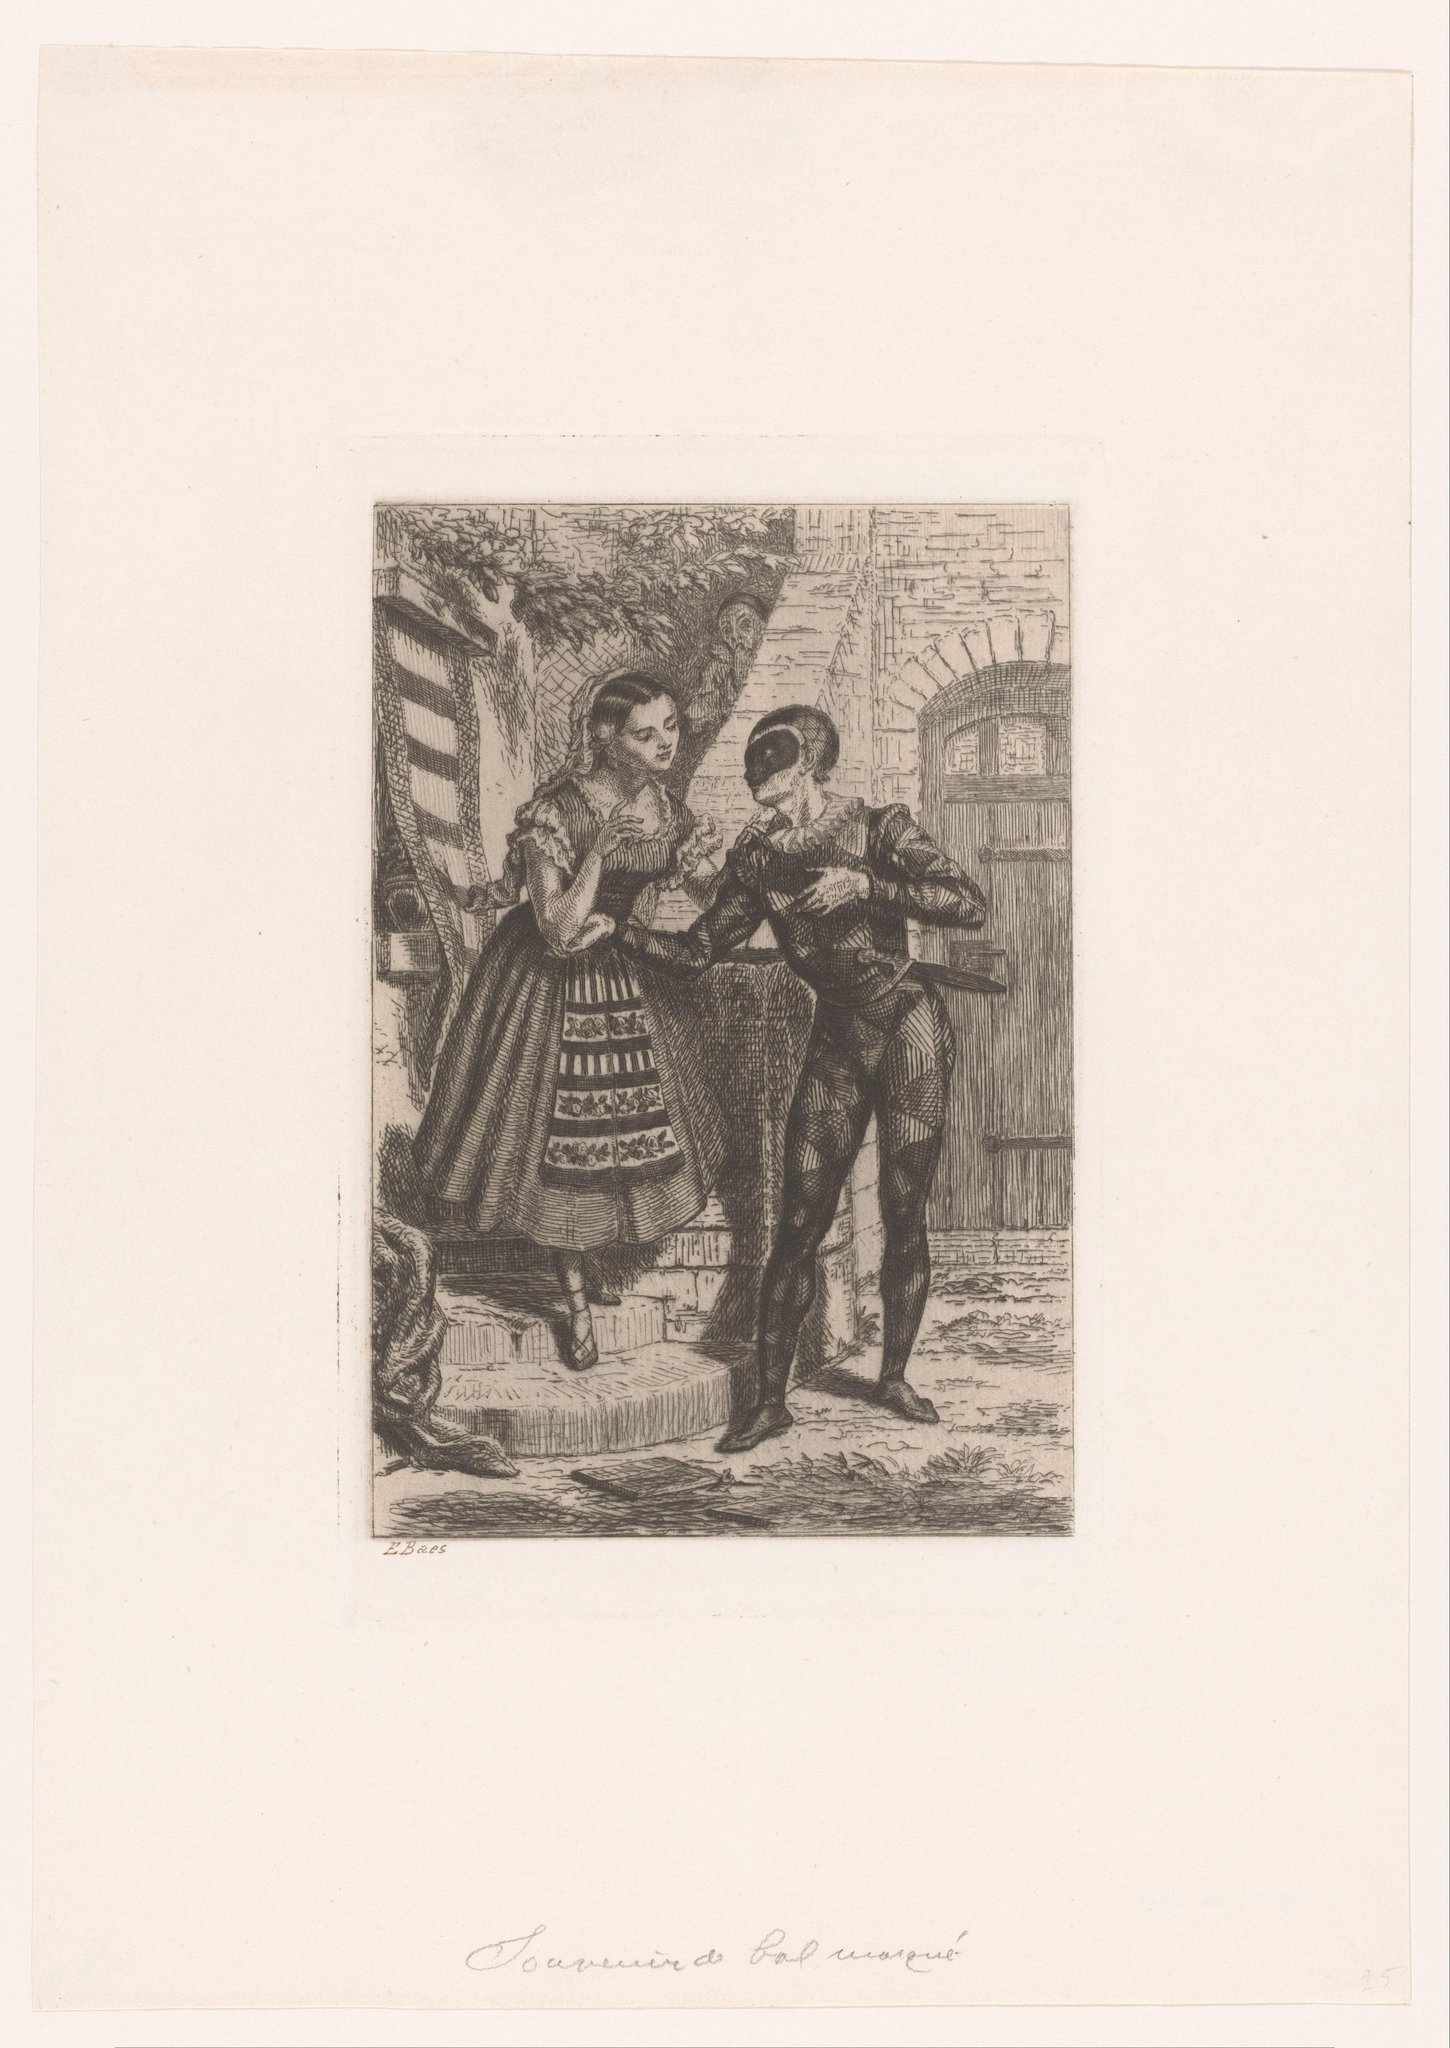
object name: print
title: Harlekijn in domino maakt een meisje het hof, Pierrot kijkt toe van de achtergrond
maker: edgar alfred baes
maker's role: print maker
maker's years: 1837-1909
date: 1847-1909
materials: paper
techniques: drypoint, etching, intaglio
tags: types in 'commedia dell'arte': pierrot, courting, types in 'commedia dell'arte': harlequin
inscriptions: annotation: ‘Souvenir de bal masqué’, collector's mark: Lugt 2228